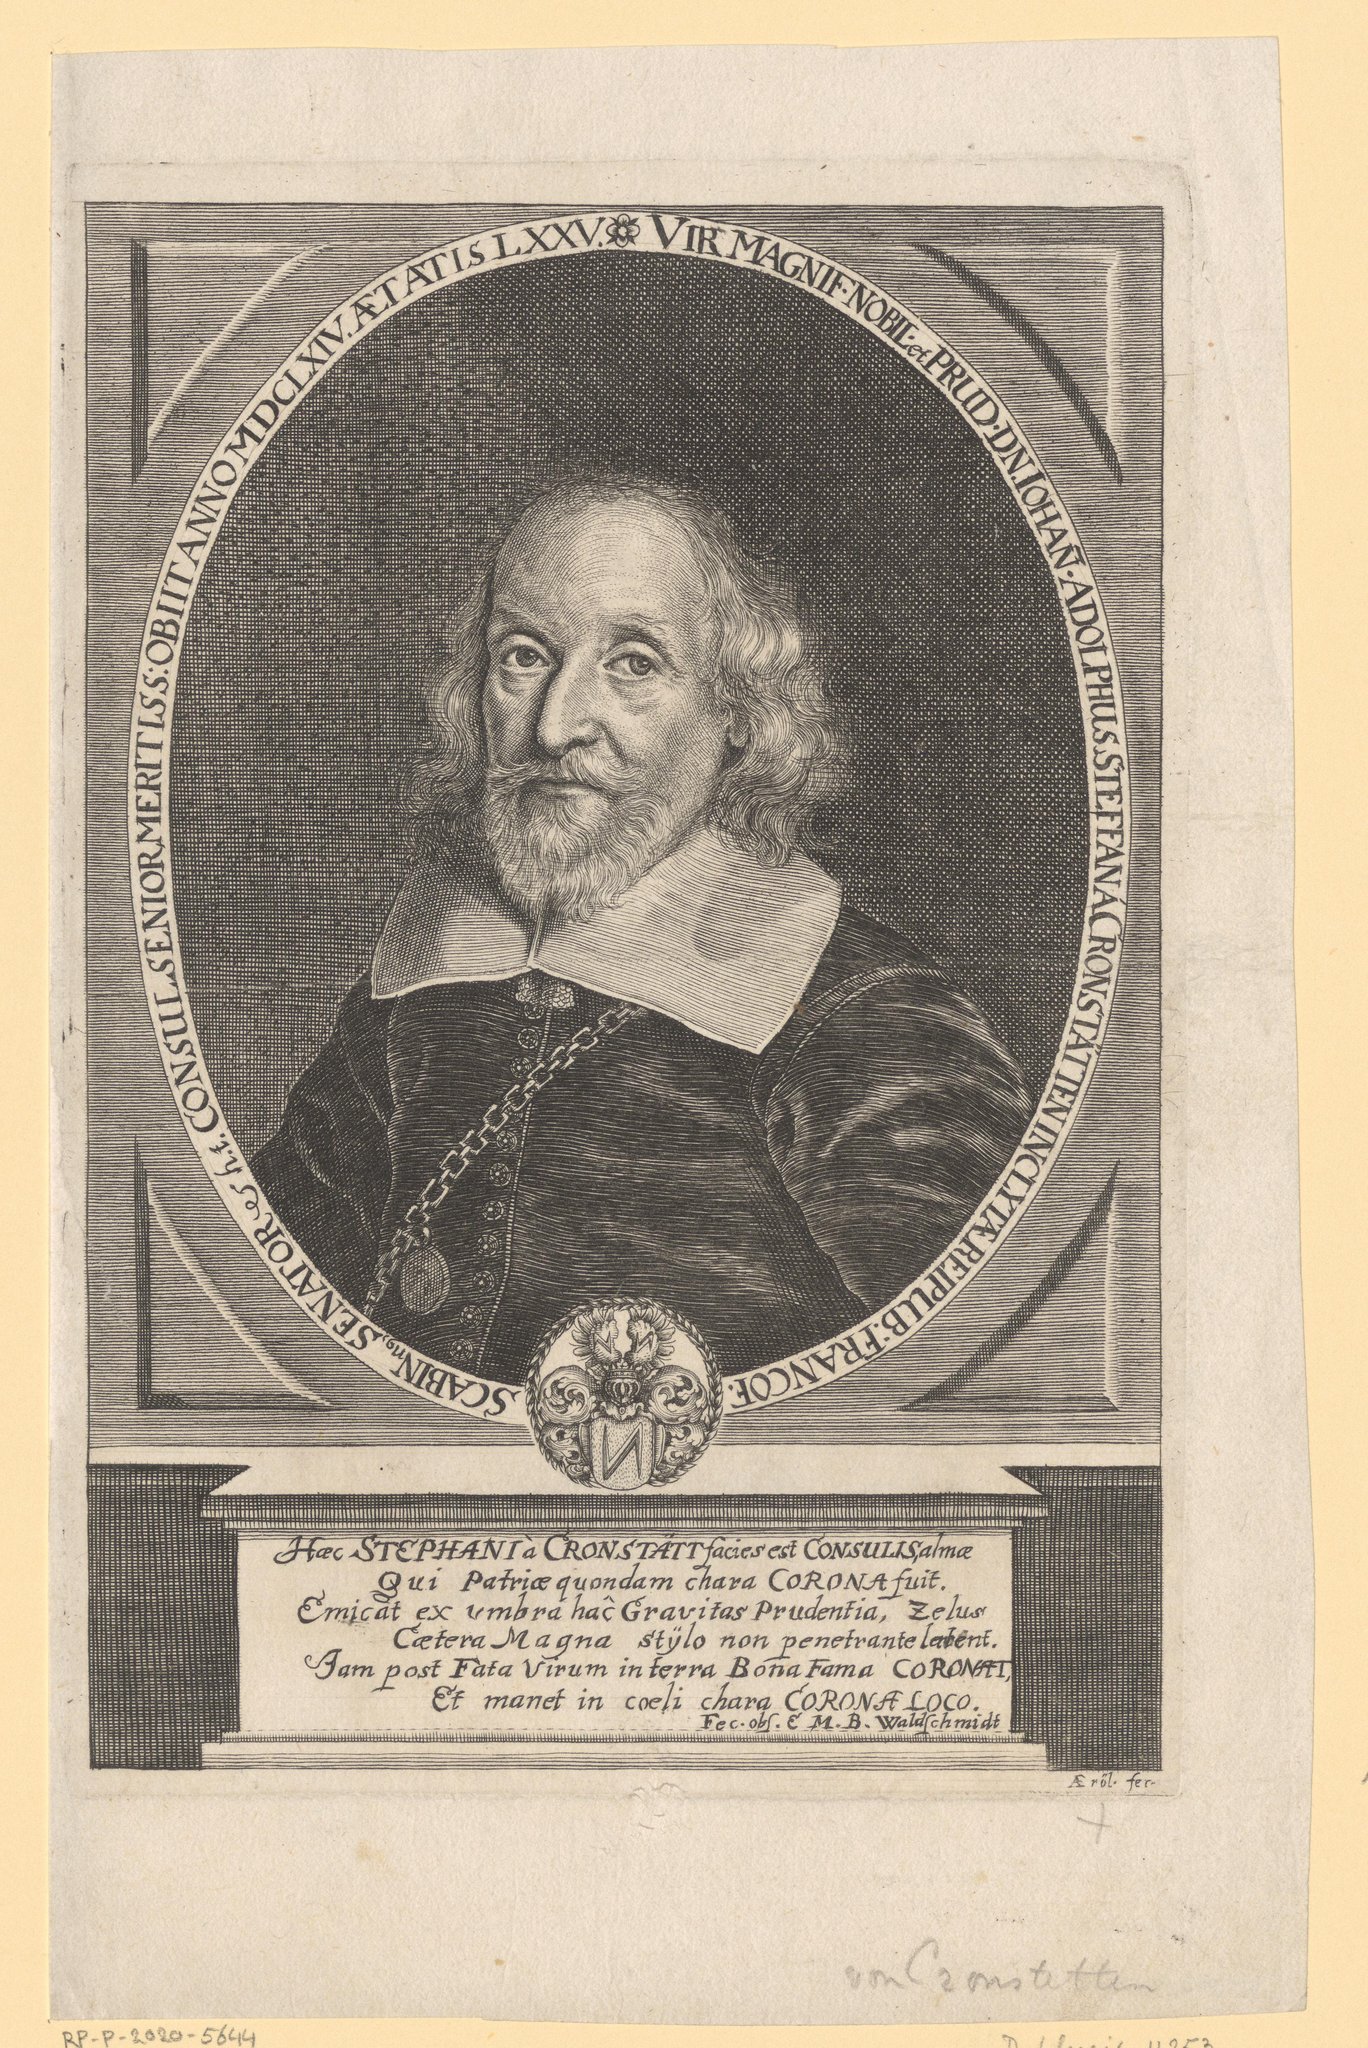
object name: print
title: Portret van Johann Adolf Steffan von Cronstetten I op 65-jarige leeftijd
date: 1750-1799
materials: paper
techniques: engraving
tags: mayor, historical persons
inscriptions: : Lugt 2228